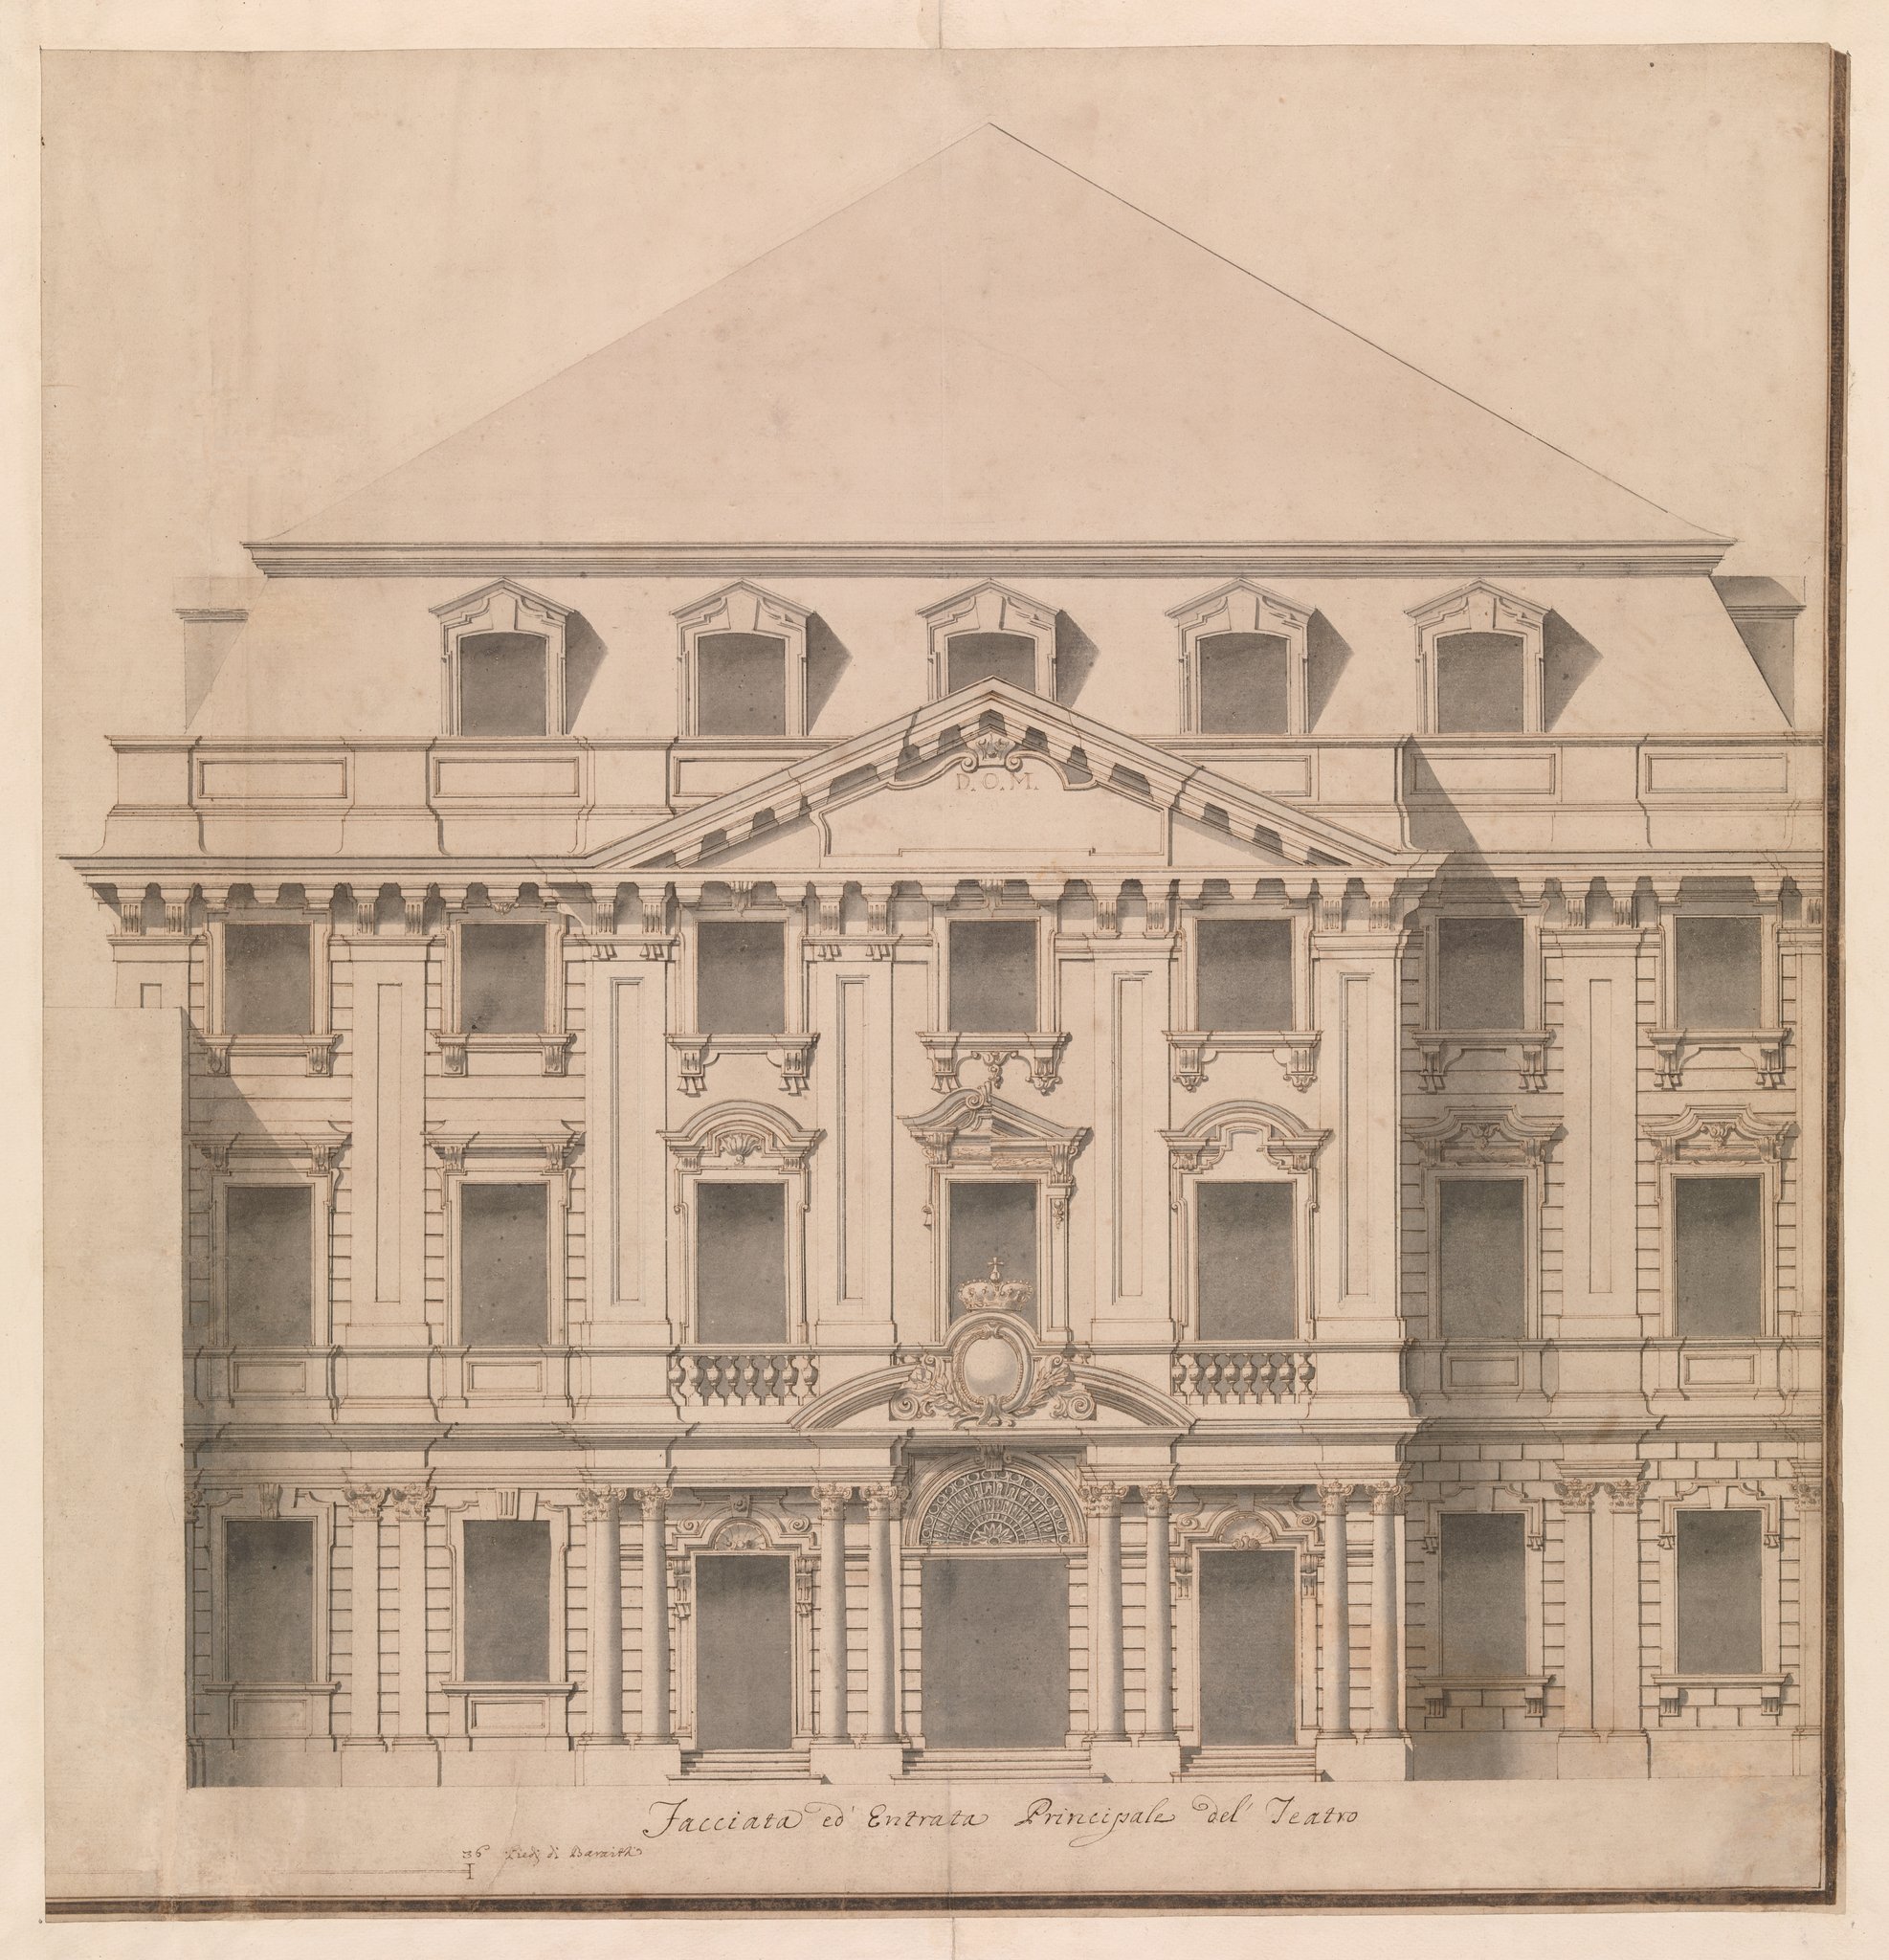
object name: drawing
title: View of a Theater (Bayreuth): Exterior Elevation of the Façade; Central Portal Surmounted by Royal Crown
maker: giuseppe galli bibiena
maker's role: artist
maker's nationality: italian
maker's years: 1696-1756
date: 1696-1756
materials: ink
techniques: pen, wash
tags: theatre,architecture